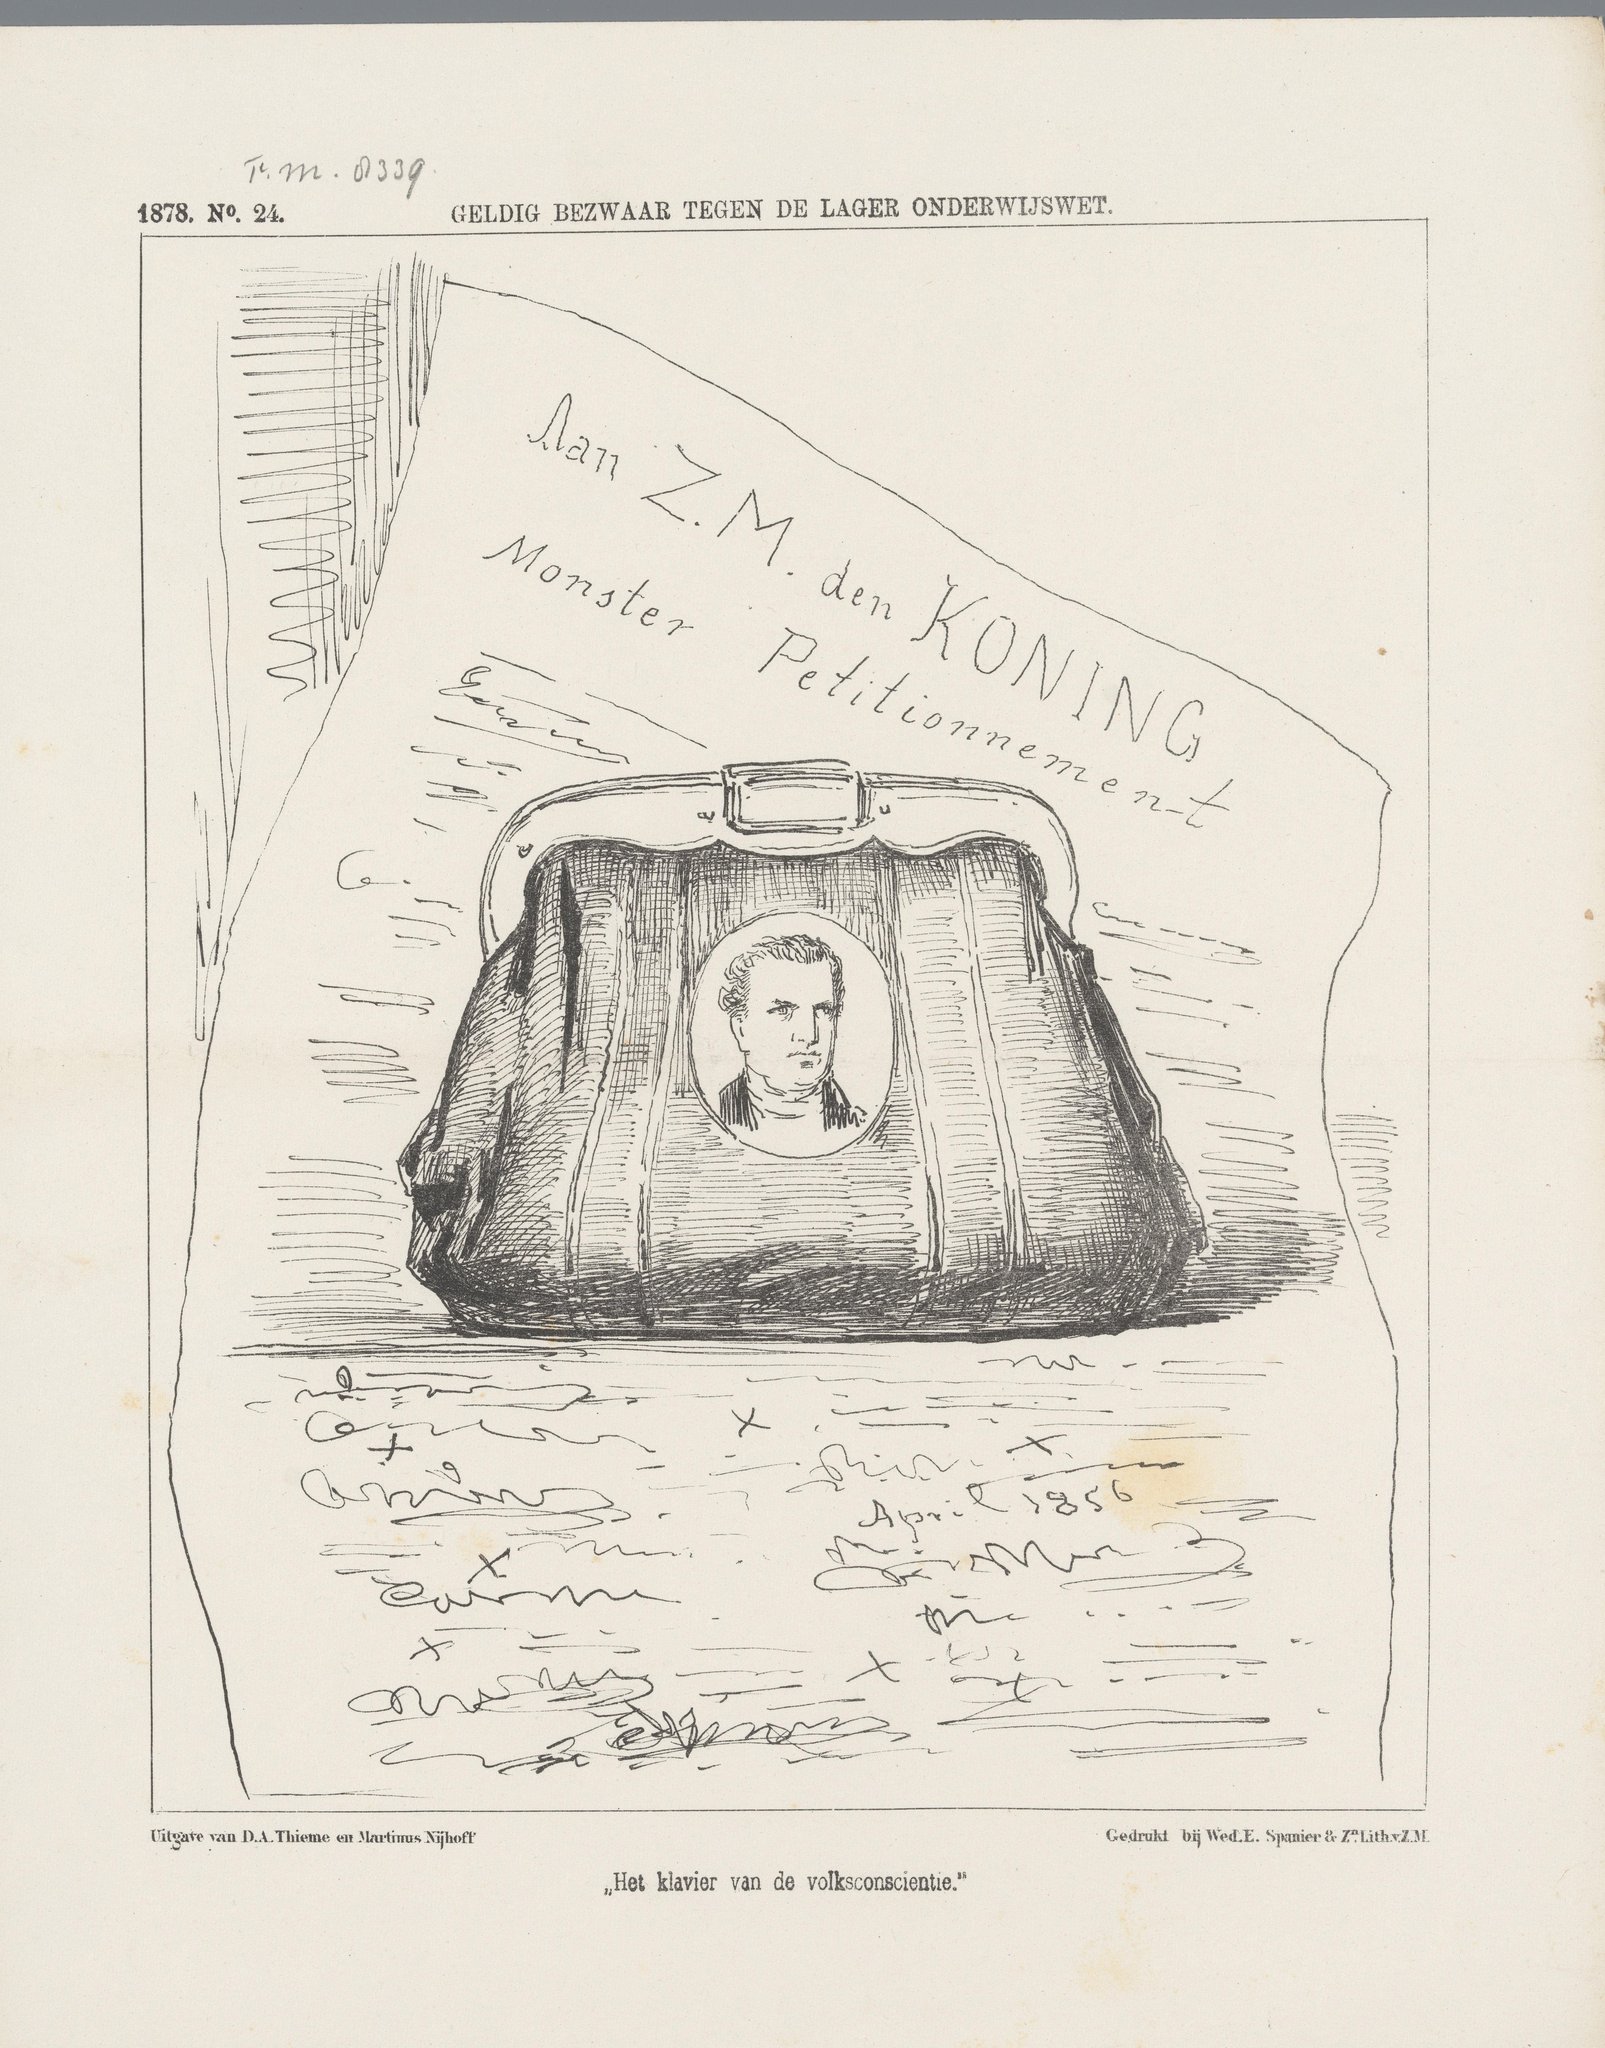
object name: print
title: Geldig bezwaar tegen de lager onderwijswet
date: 1878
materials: paper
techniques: lithograph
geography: arnhem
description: Spotprent. Plaat verschenen bij het weekblad De Nederlandsche Spectator, nr. 24, 1878.